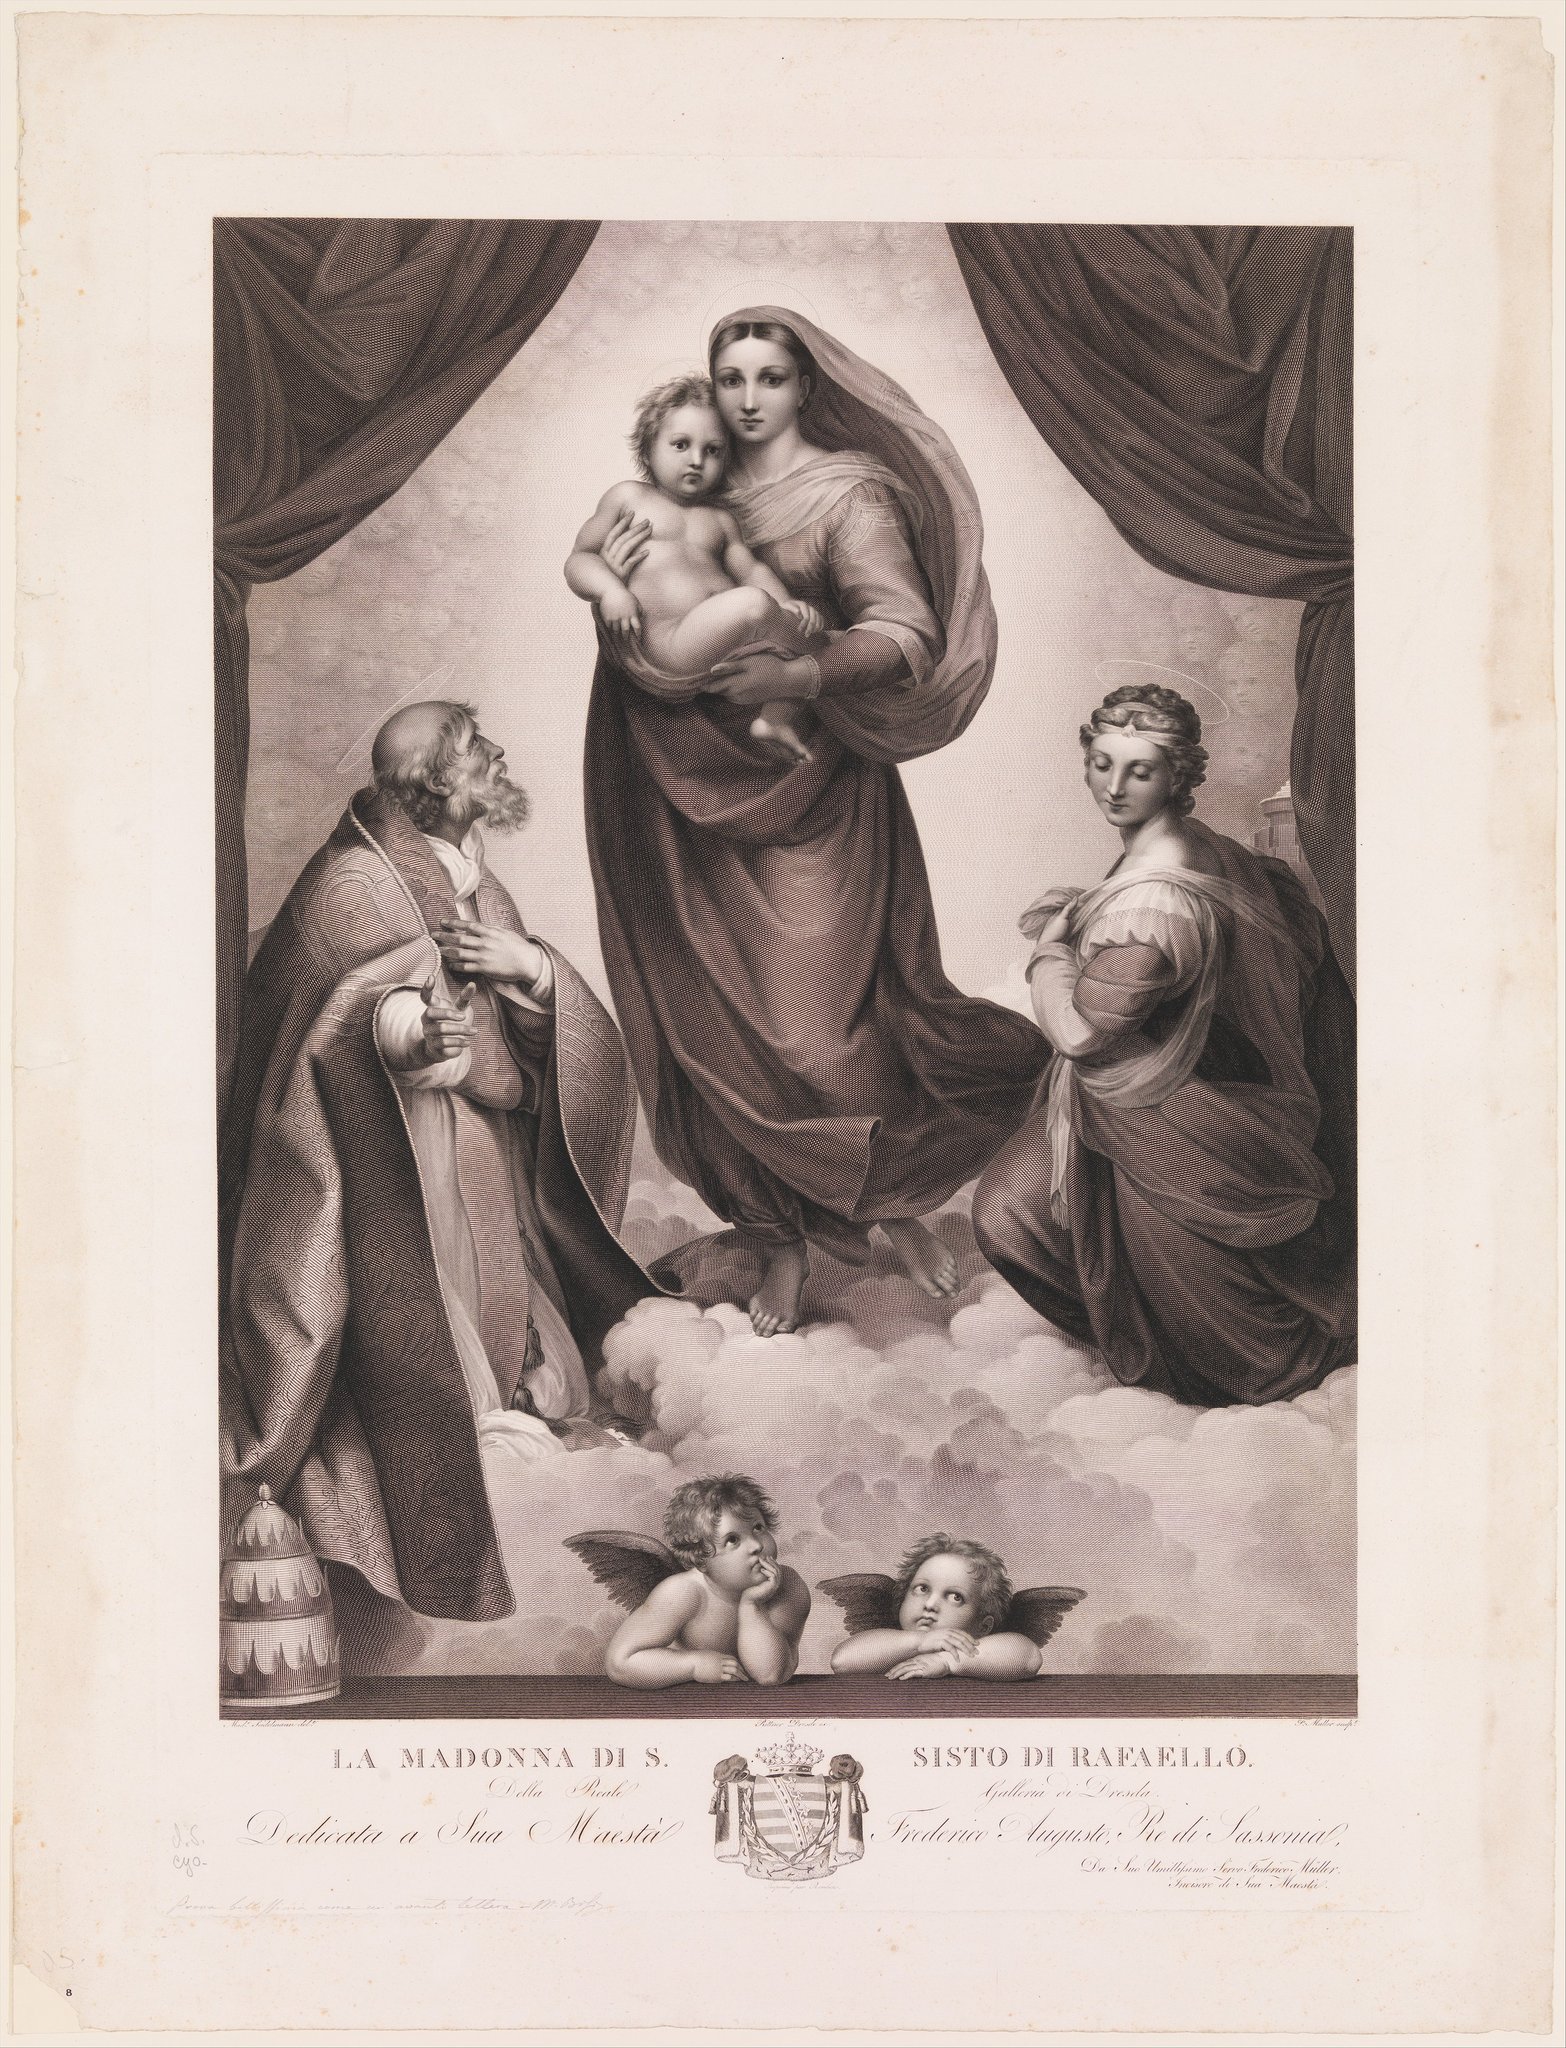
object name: print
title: The Sistine Madonna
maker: johann friedrich wilhelm müller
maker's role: draughtsman, print maker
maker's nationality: german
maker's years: 1782-1816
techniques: engraving, etching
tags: men,women,angels,madonna and child